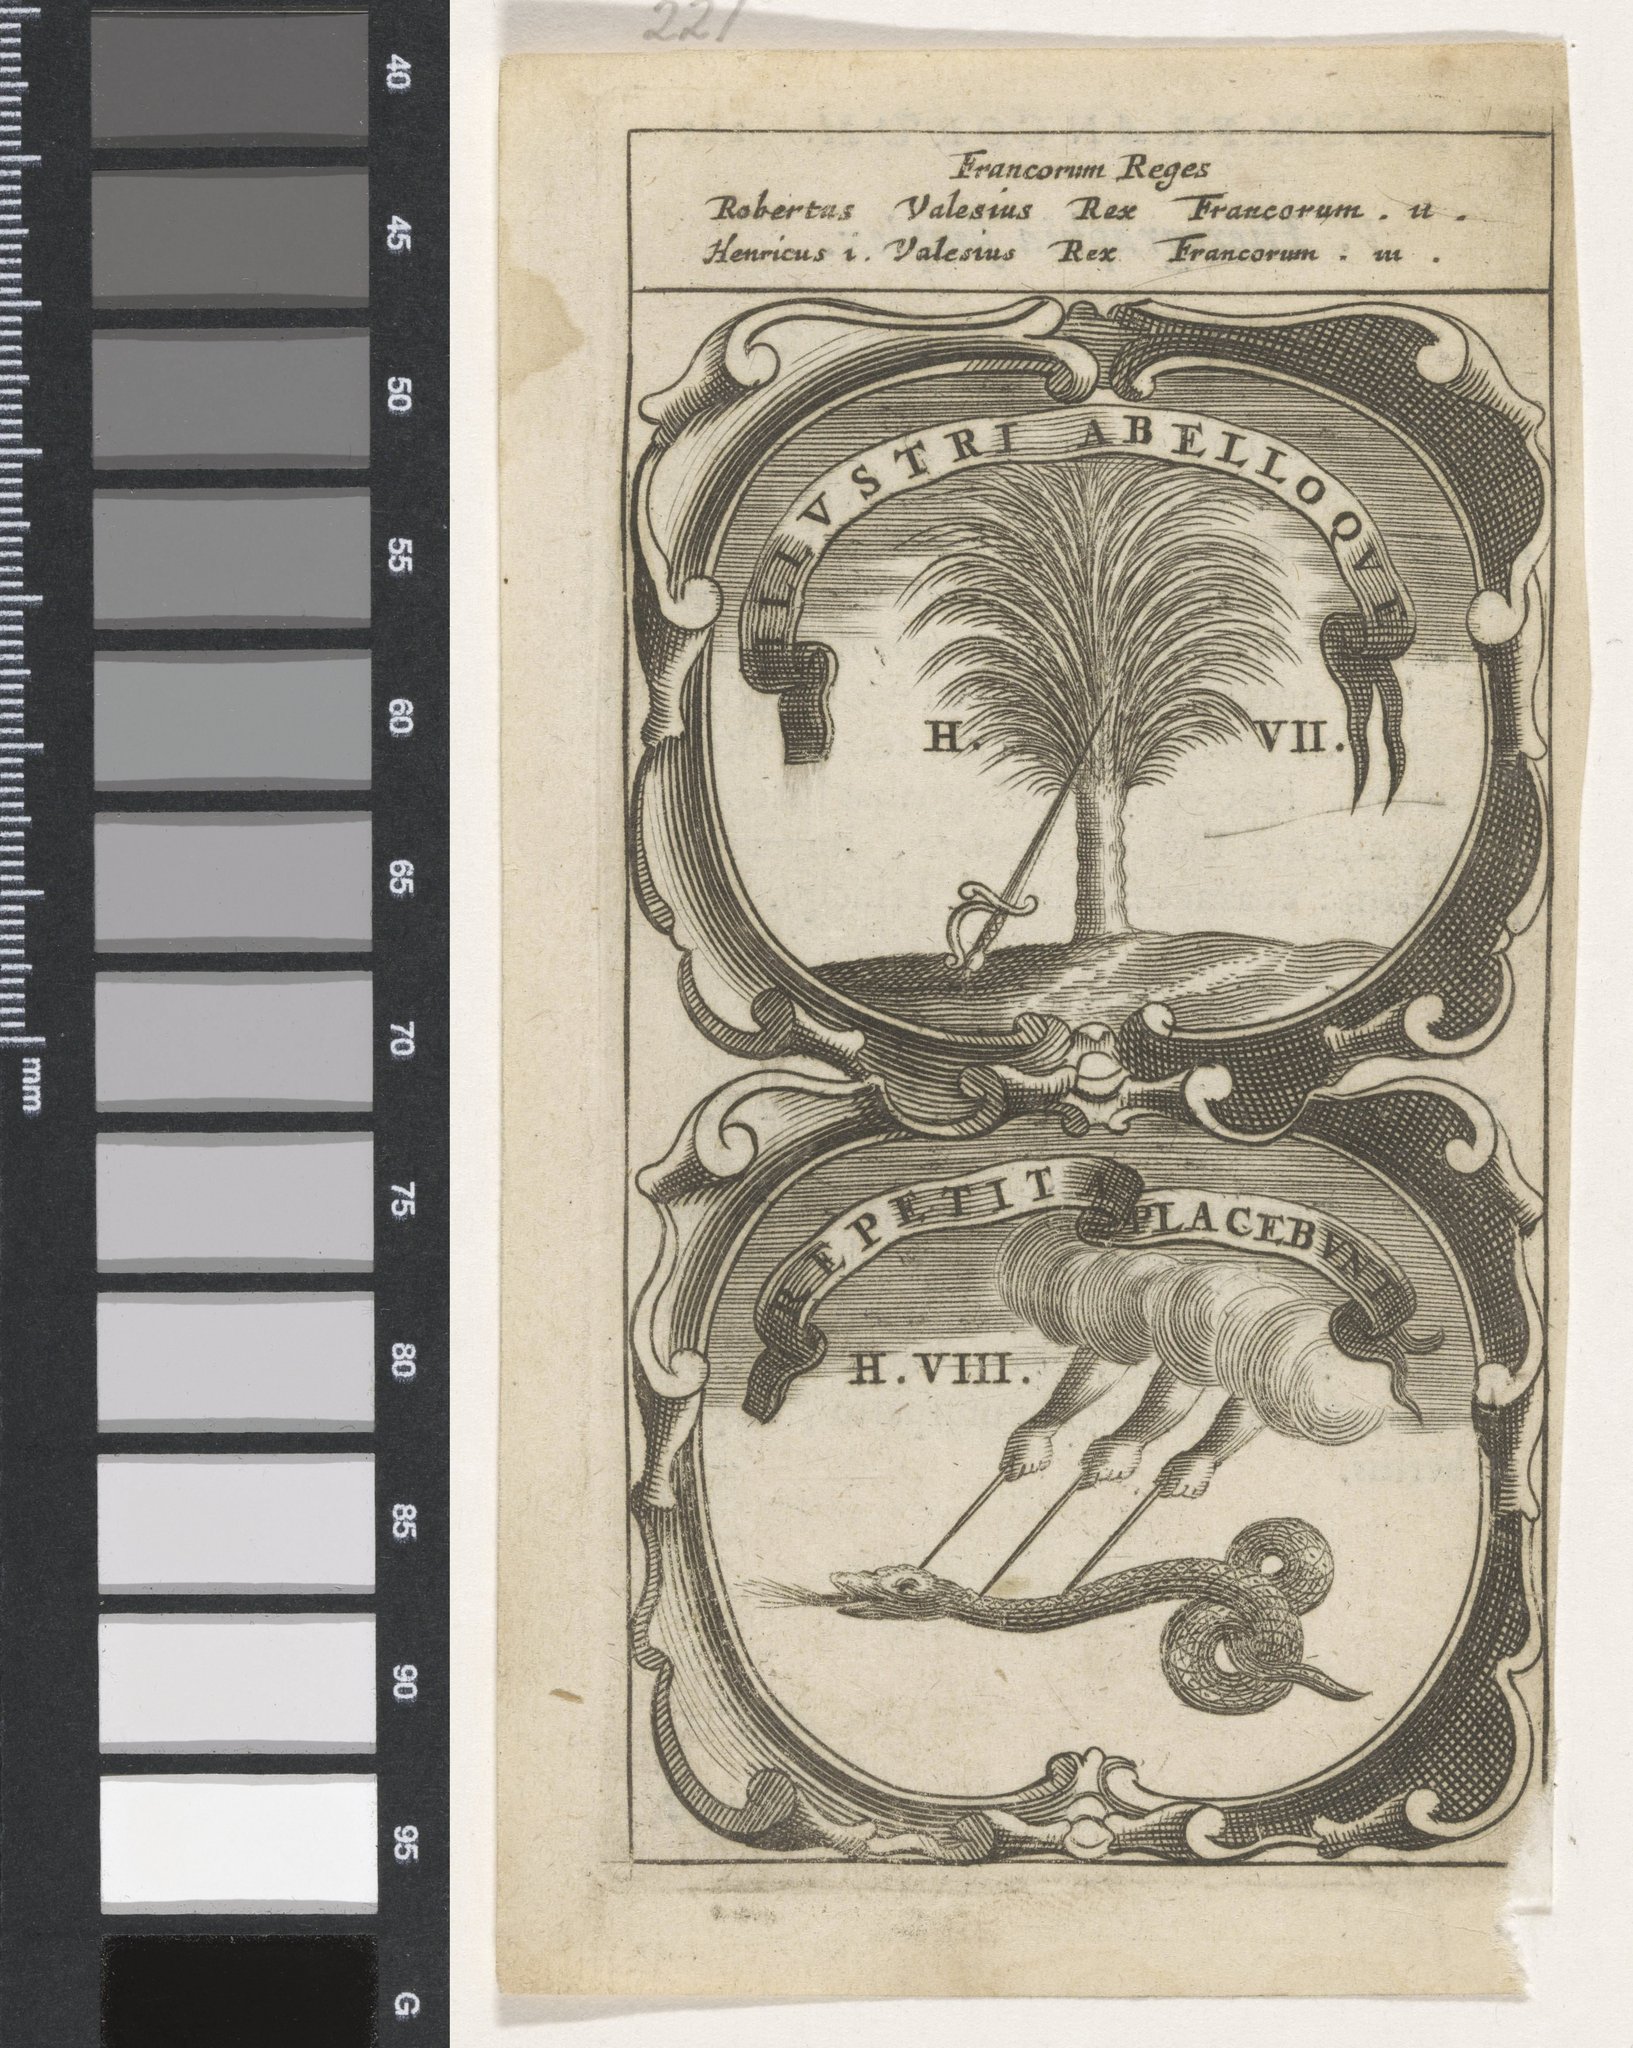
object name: print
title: Illustri Abelloque / Repetita Placebunt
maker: Anonymous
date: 1666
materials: paper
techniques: engraving, letterpress printing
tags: snakes, hacking and thrusting weapons: sword, postures and gestures of arms and hands, trees: palm-tree, man killing animal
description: Pagina uit Jacob Typotius, Symbola Divina & Humana Pontificum Imperatorum Regum. Arnhem, J.F. Hagen, 1666 of uit de titeluitgave van 1669 of 1679. Het werk van Typotius werd voor het eerst uitgegeven in 1601 met prenten van Aegidius Sadeler.